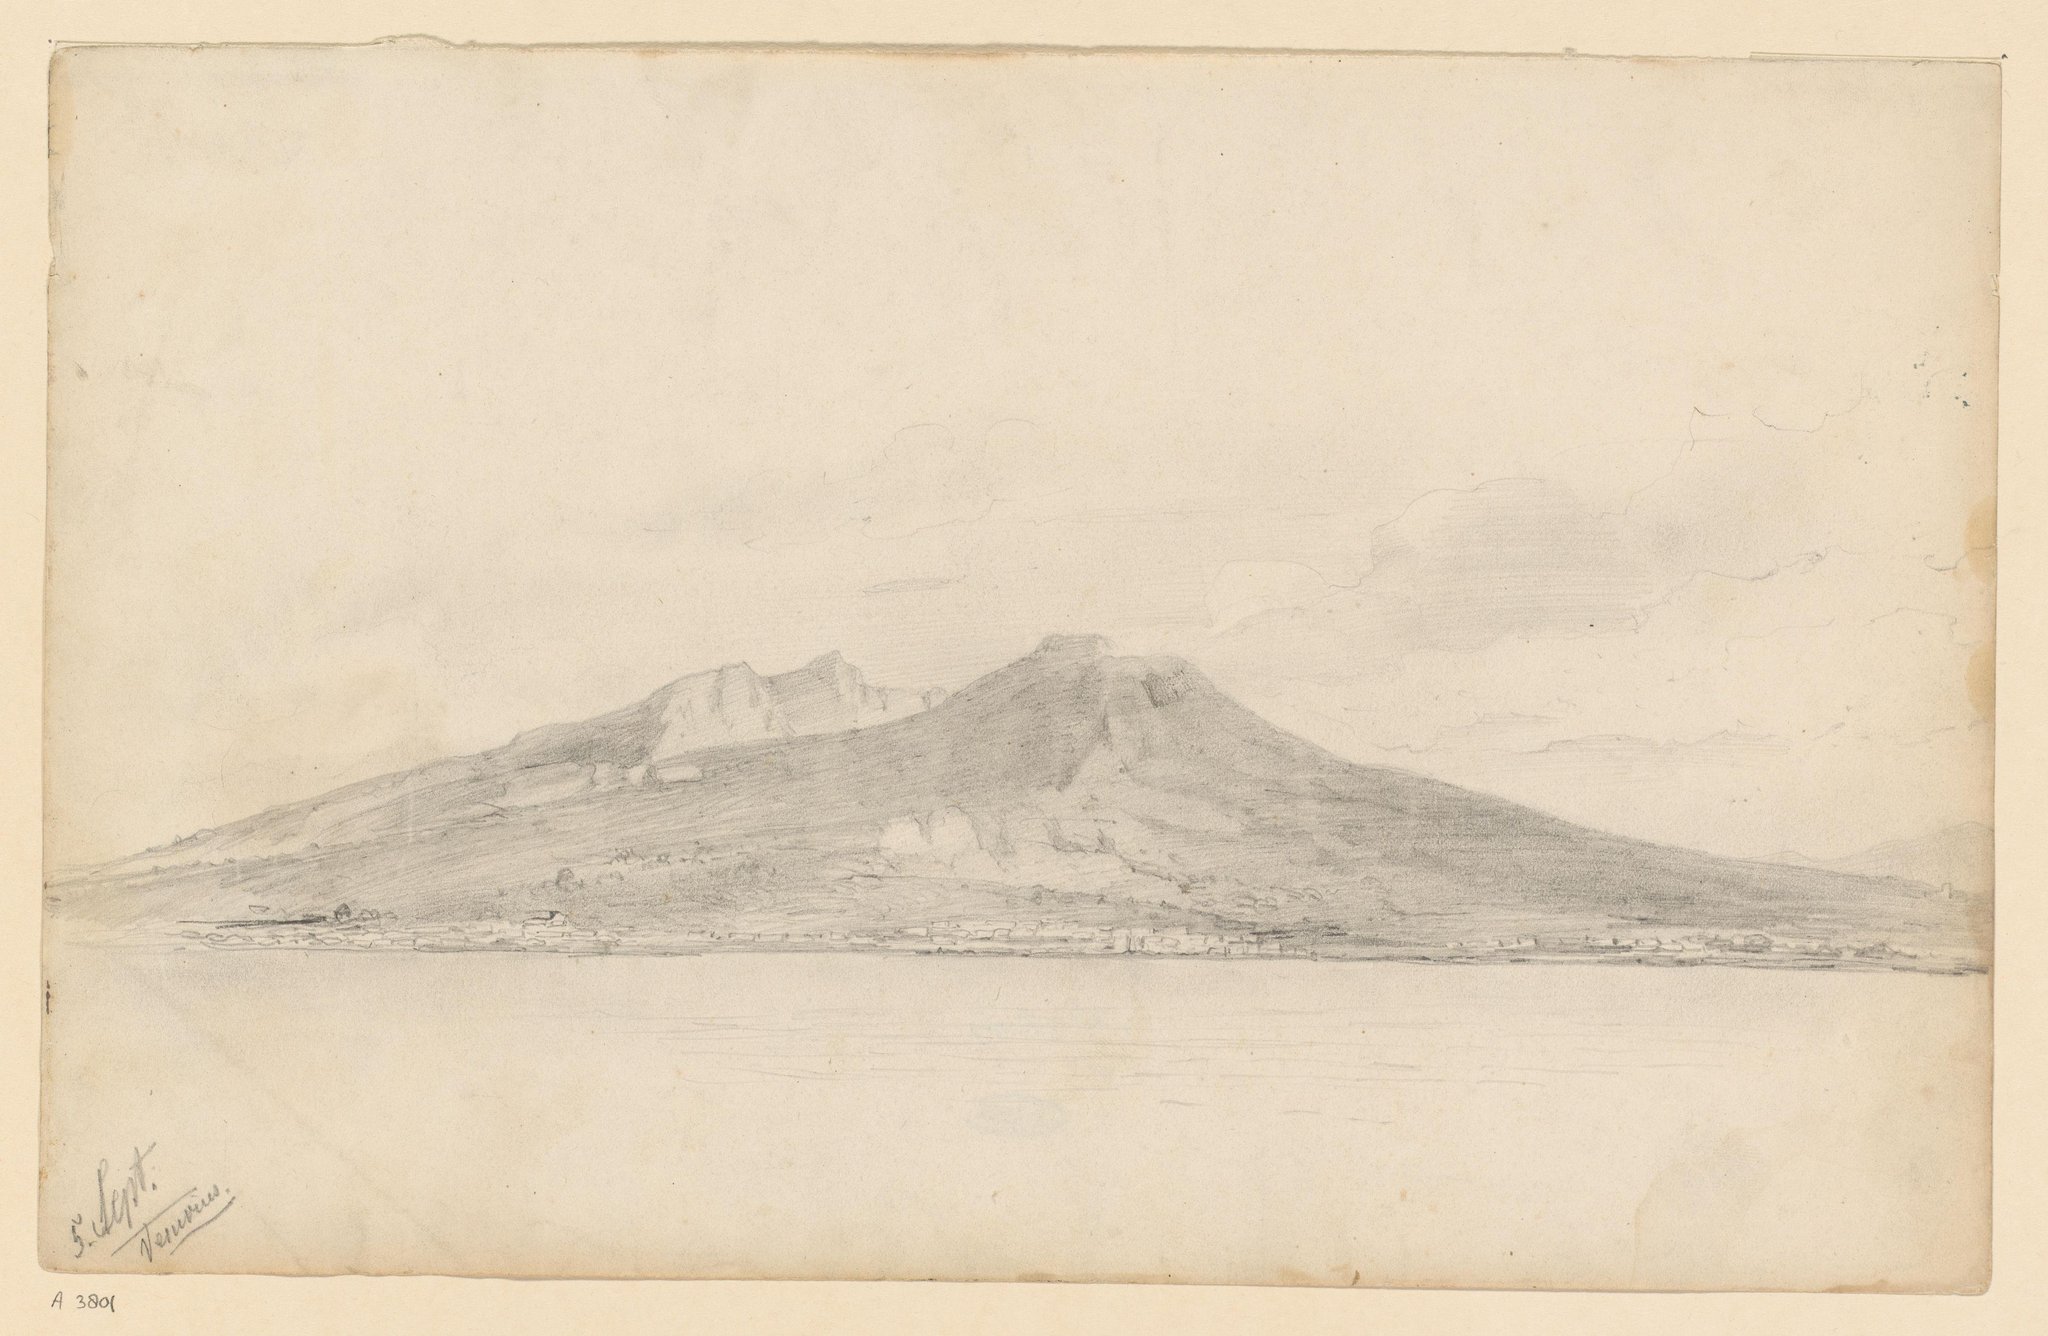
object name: drawing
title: De Vesuvius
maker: willem anthonie van deventer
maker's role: draughtsman, painter, print maker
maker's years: 1824-1893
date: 1834-1893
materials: paper, pencil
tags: volcano, italy, mount vesuvius